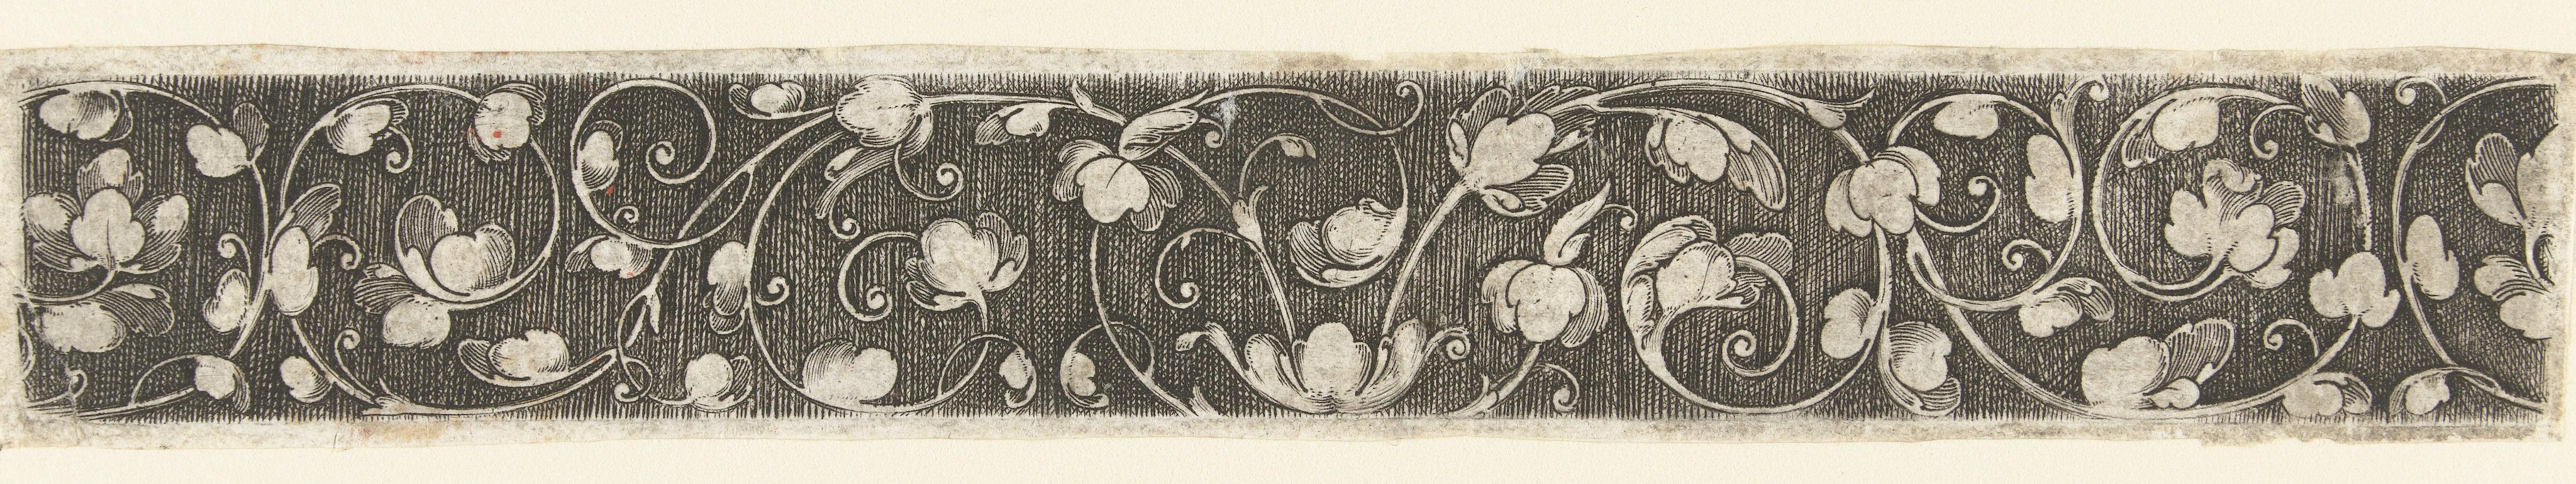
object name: ornament print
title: Bladranken die in het midden ontspruiten uit een liggende bloem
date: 1500-1600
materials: paper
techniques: engraving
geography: germany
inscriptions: collector's mark: Lugt 240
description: De bladranken verspreiden zich naar beide zijden asymmetrisch over het blad. Gearceerde achtergrond. Eén van 11 bladen.